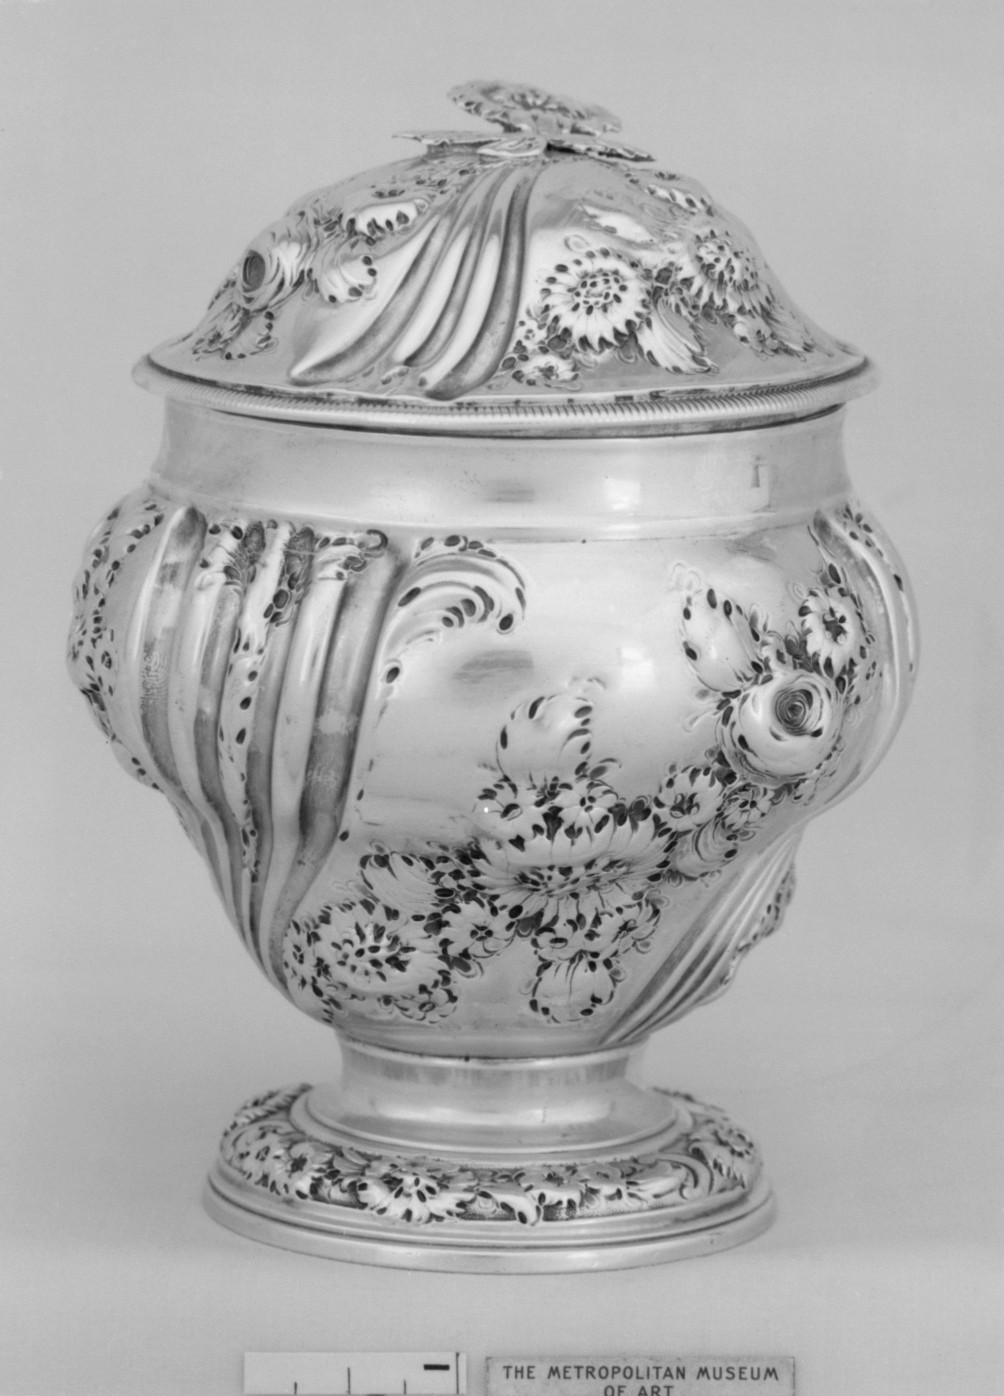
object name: sugar bowl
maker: samuel taylor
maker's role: maker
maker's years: 1744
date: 1751-1752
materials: silver